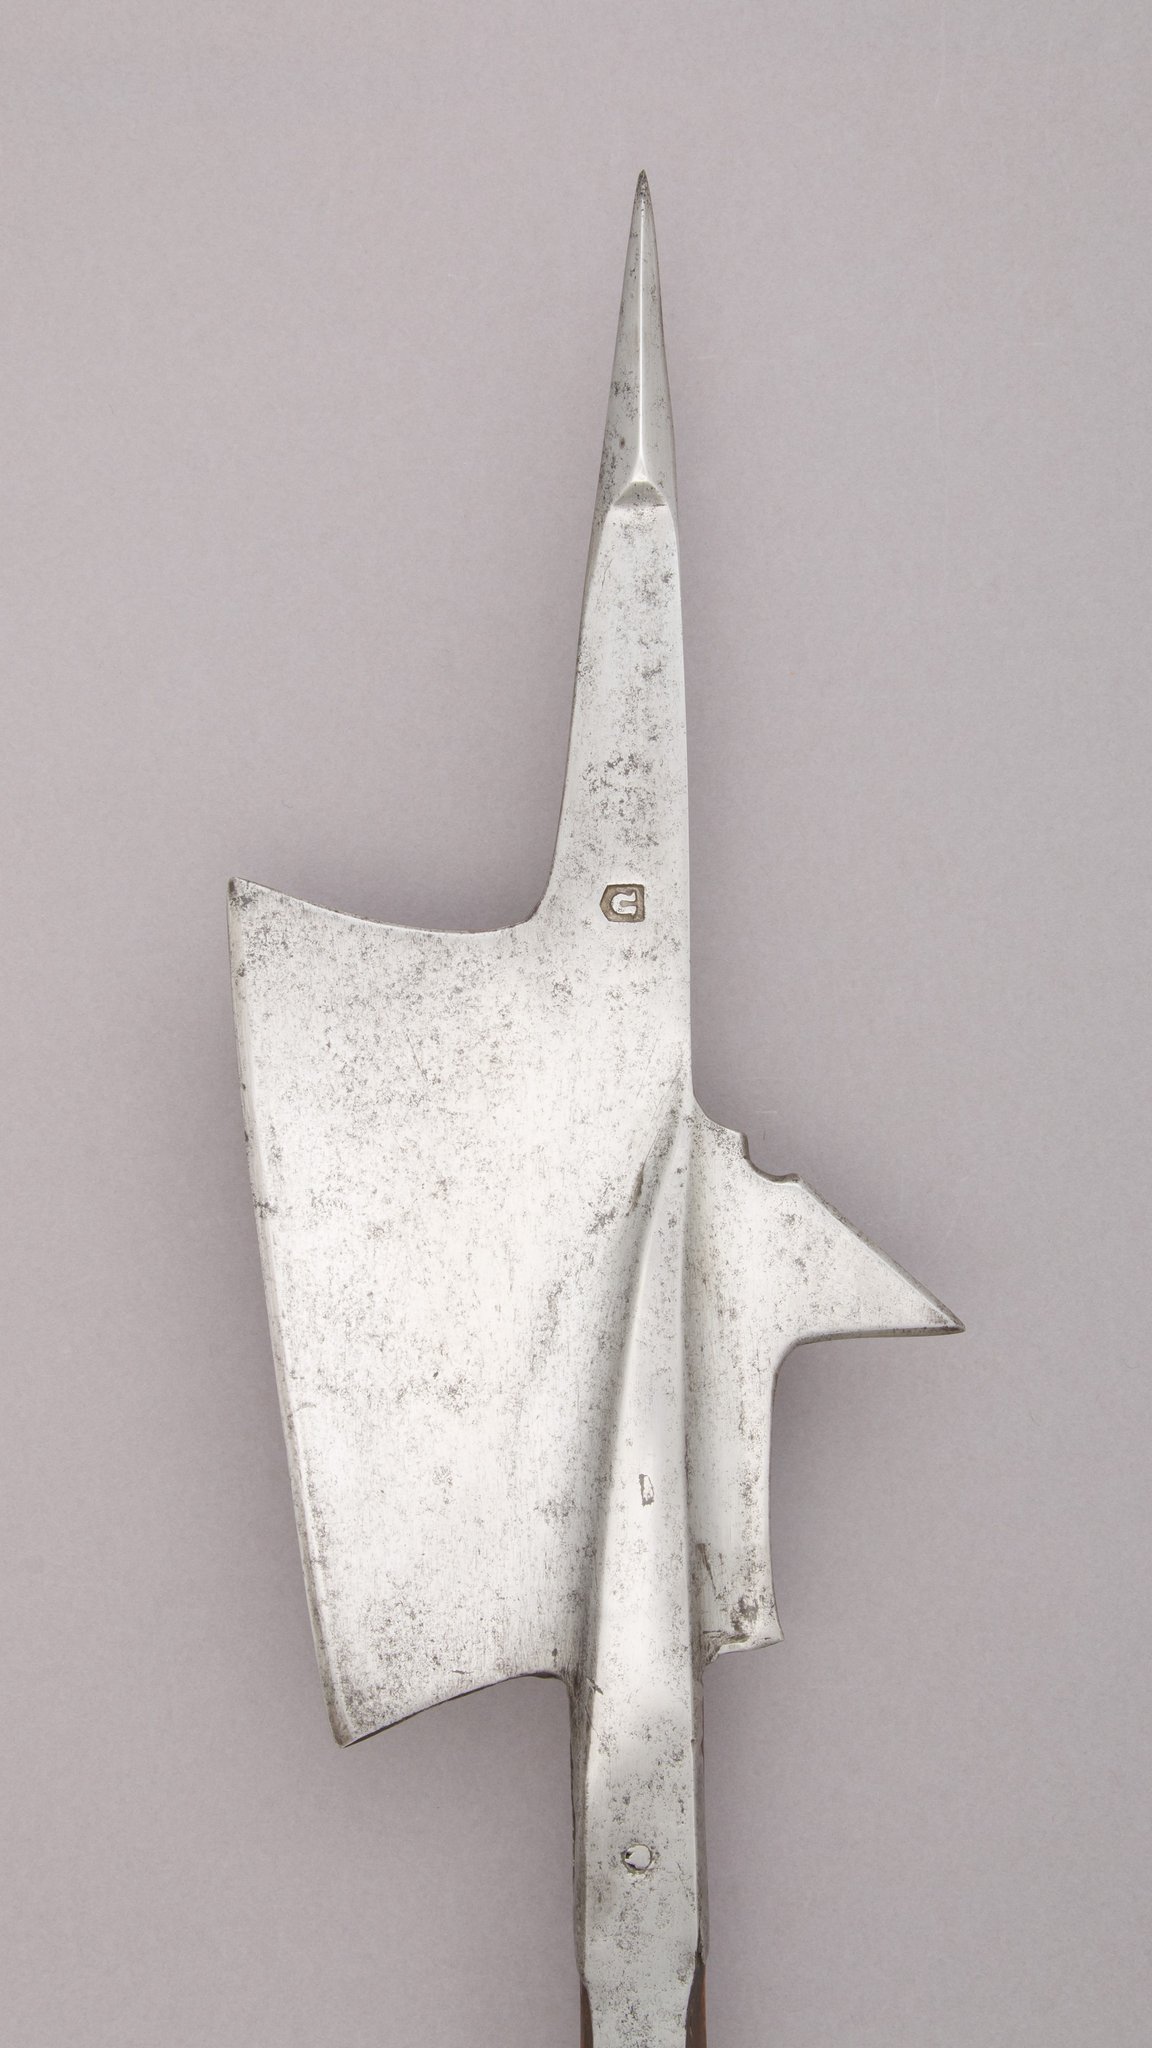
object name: halberd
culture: swiss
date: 1451-1475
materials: iron, steel, wood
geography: switzerland